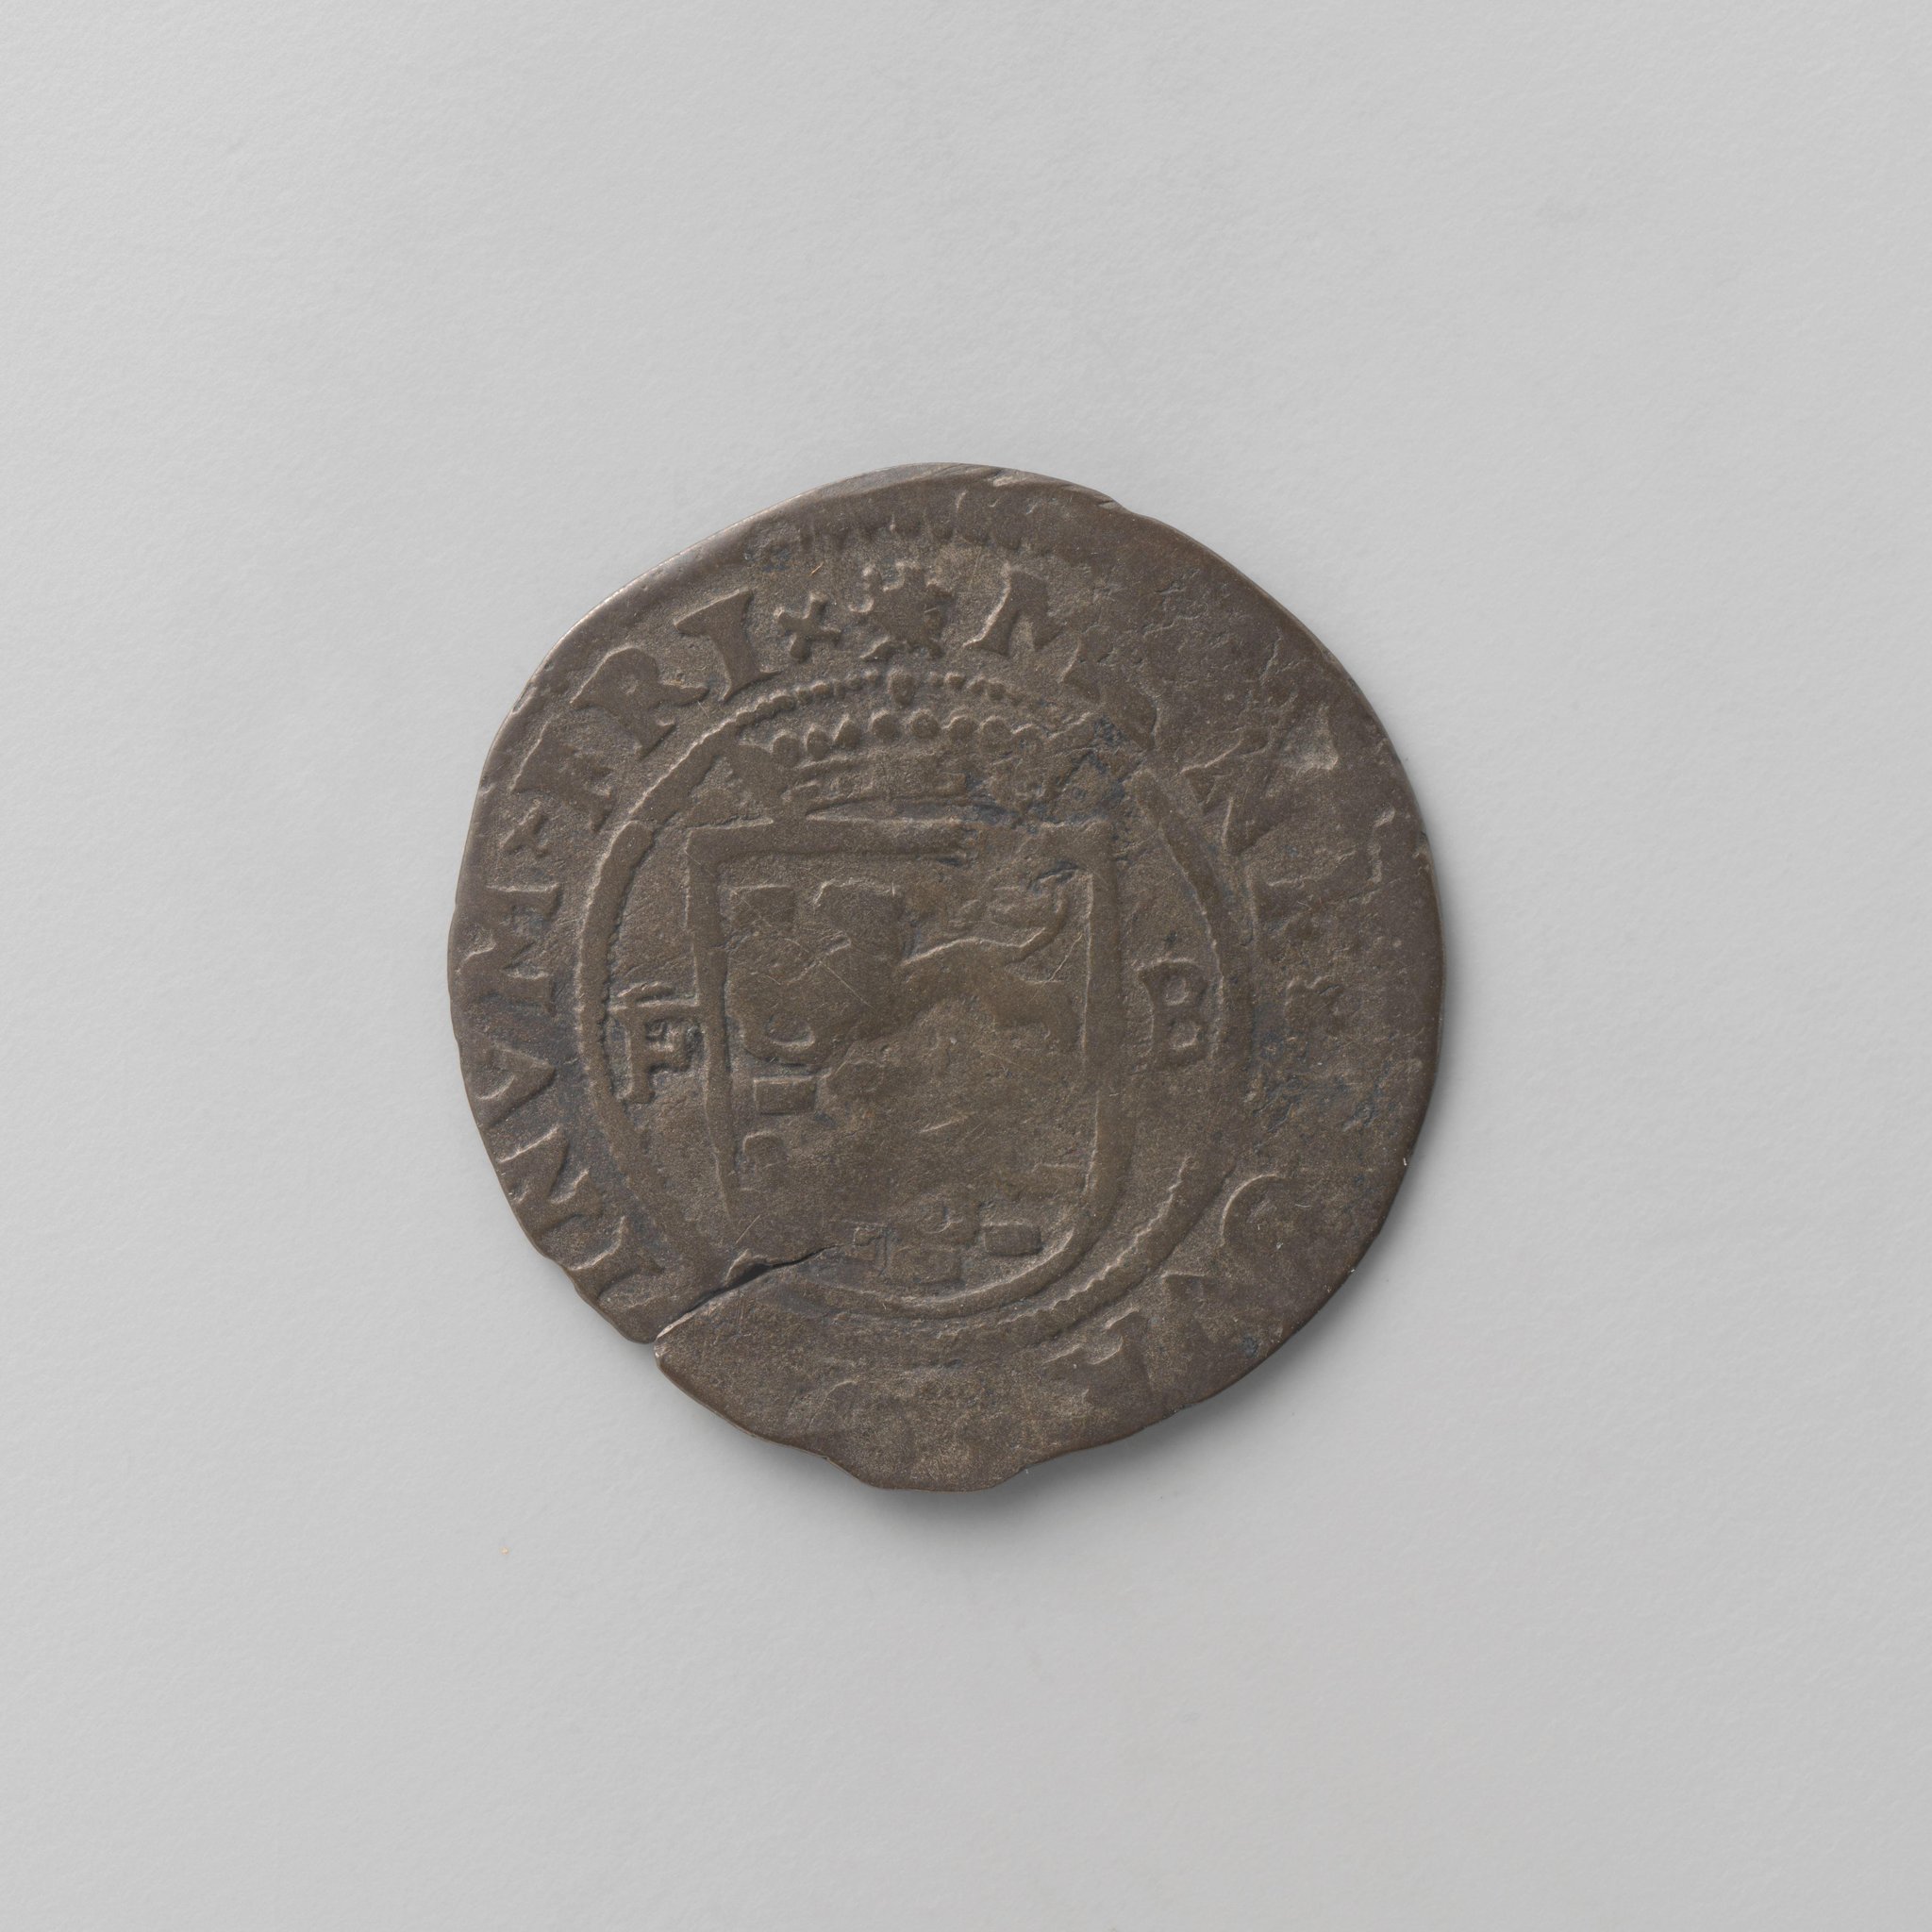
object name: coin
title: Friesland, halve stuiver of Fries butken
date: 1590-1610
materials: silver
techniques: striking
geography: leeuwarden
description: Voorzijde: tussen waarde-aanduiding F B gekroond wapenschild van Friesland. Keerzijde: lang dubbellijnig versierd kruis met in hart leeuwtje en in hoeken de letters B, F, B en F.